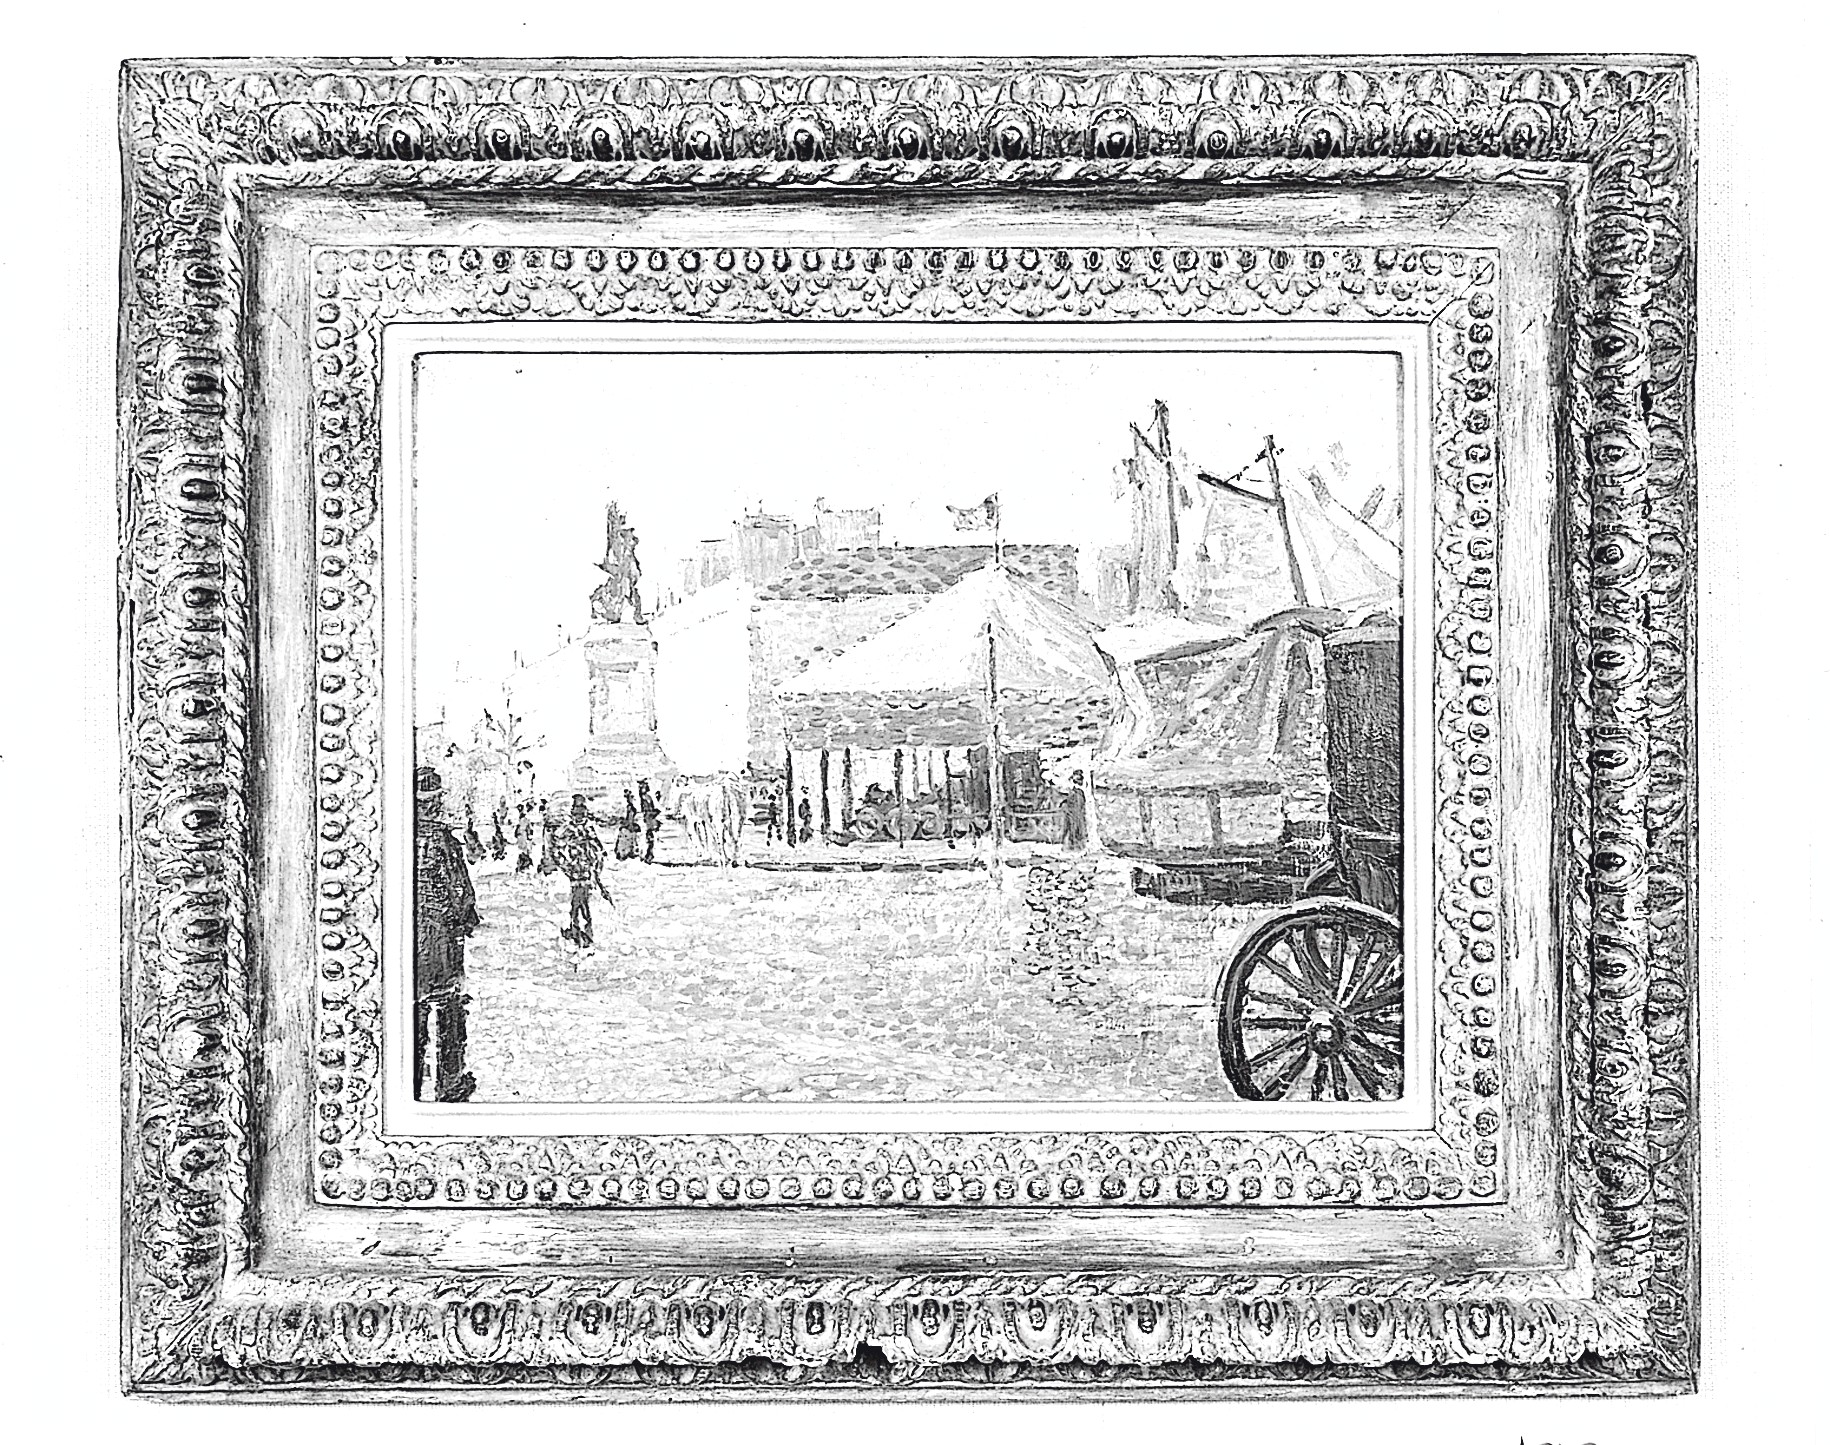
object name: frame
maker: italian (roman)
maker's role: artist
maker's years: 1700-1745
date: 1701-1733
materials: wood